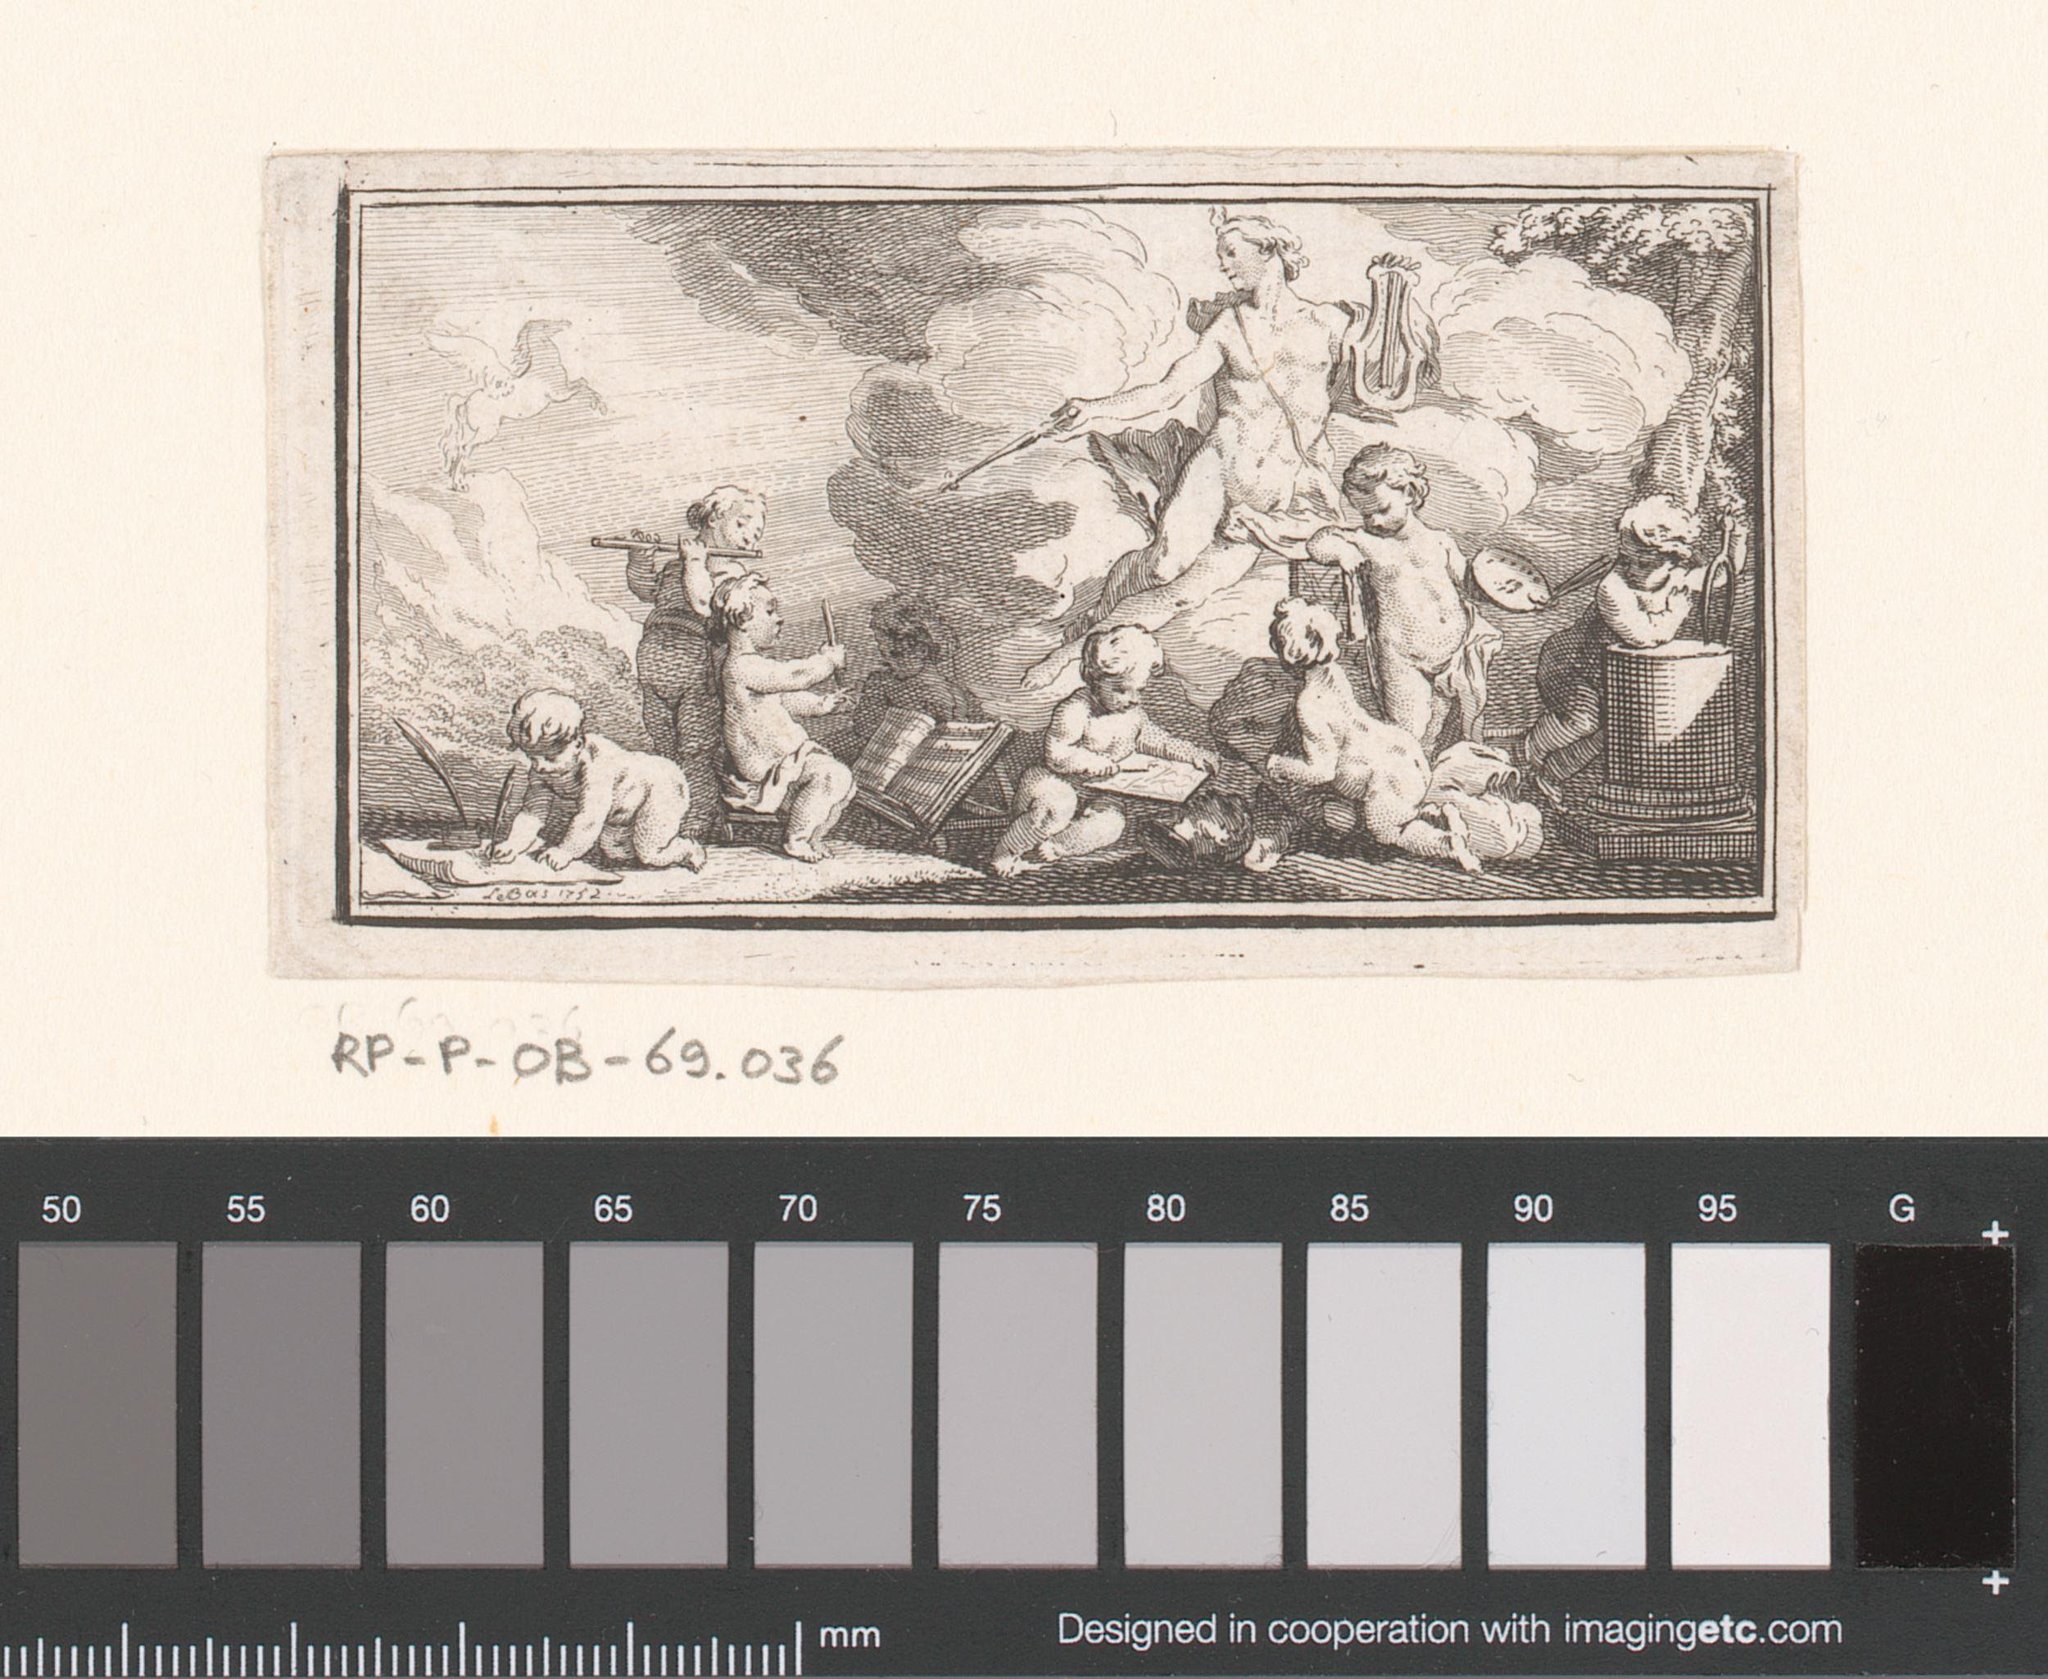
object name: print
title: Apollo met musicerende en schilderende putti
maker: jacques-philippe le bas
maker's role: draughtsman, print maker, publisher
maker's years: 1707-1783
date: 1752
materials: paper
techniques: etching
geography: paris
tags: (story of) apollo (phoebus), cupids: 'amores', 'amoretti', 'putti'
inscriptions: collector's mark: Lugt 2228